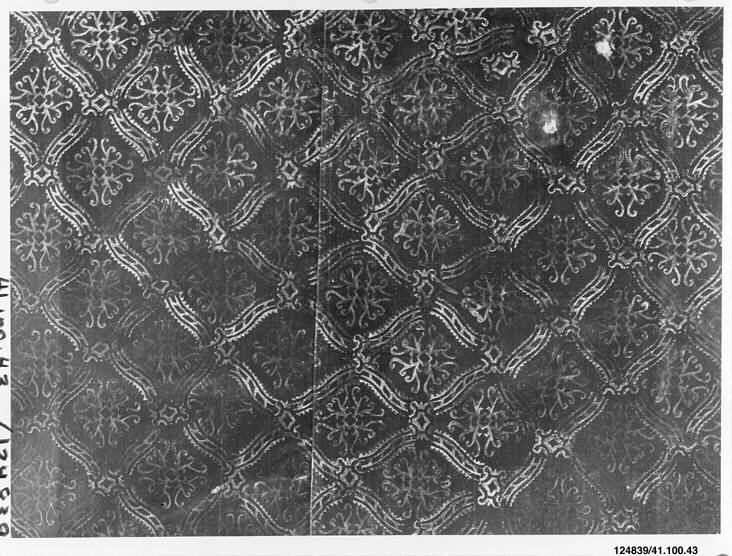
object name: piece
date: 1501-1600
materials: silk